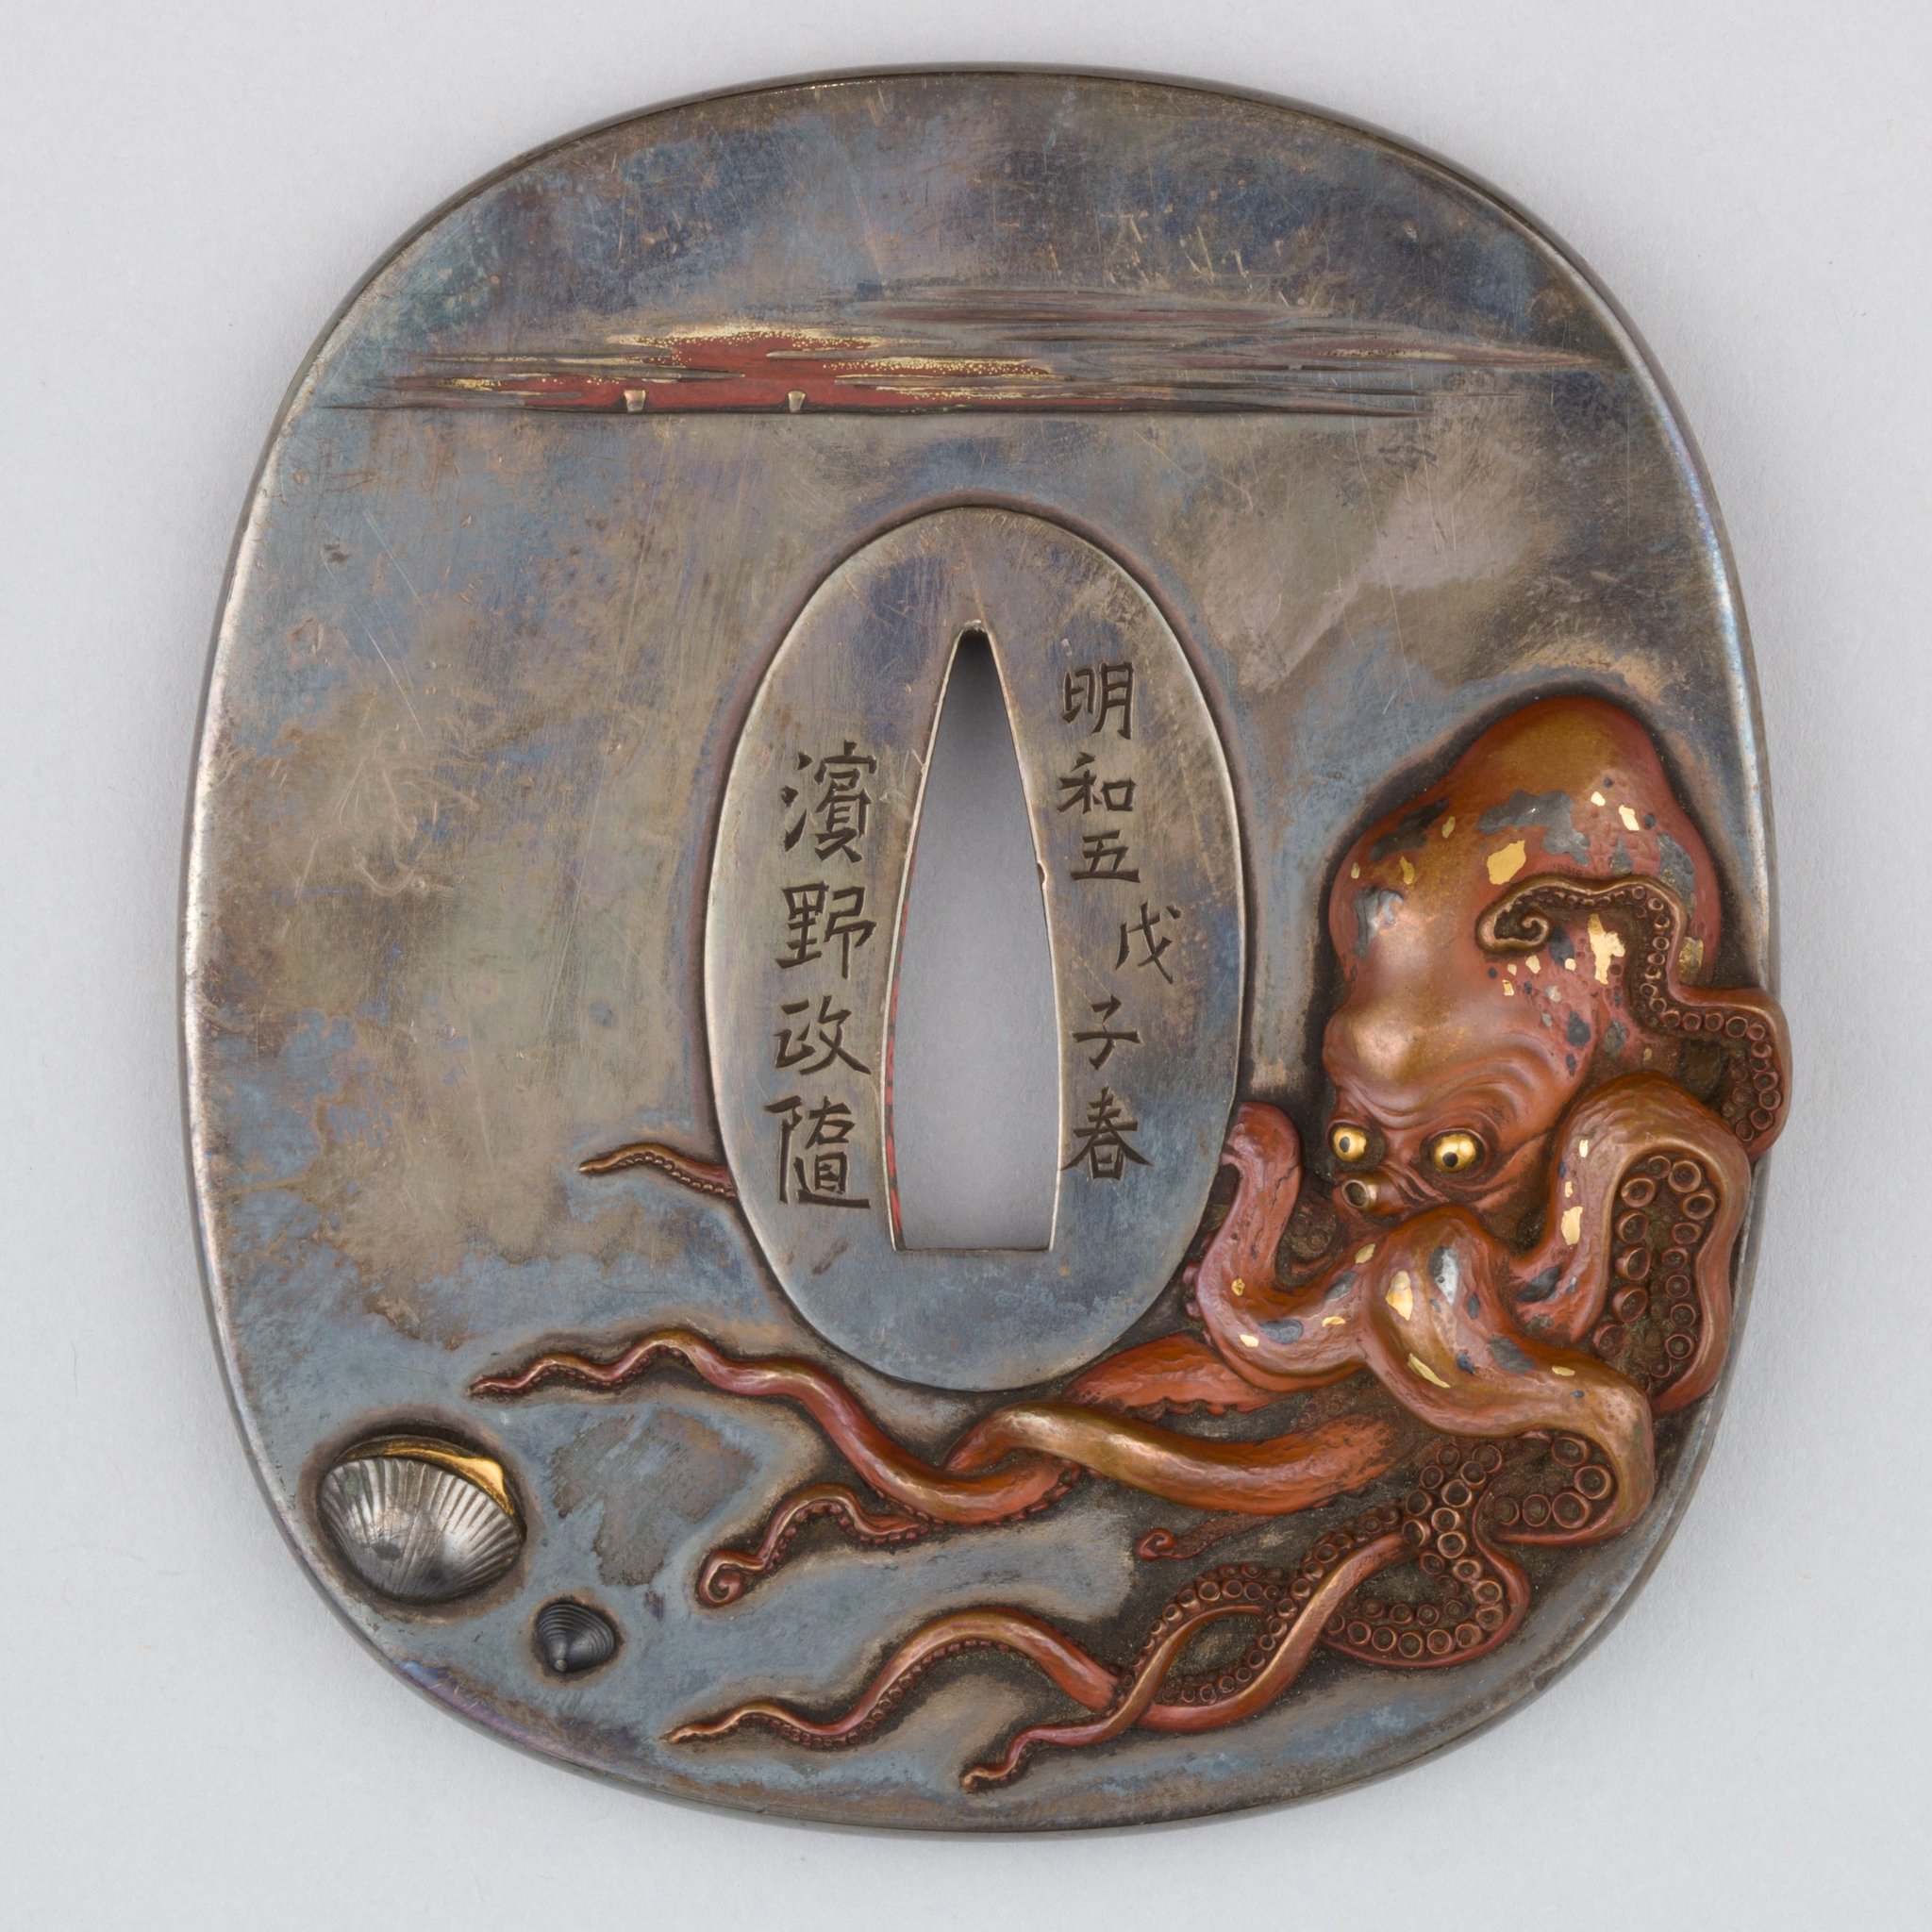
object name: sword guard tsuba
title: Sword Guard (Tsuba)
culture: japanese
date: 1615-1868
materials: copper, copper alloy, gold alloy, silver alloy, gold, silver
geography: japan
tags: octopus,shells